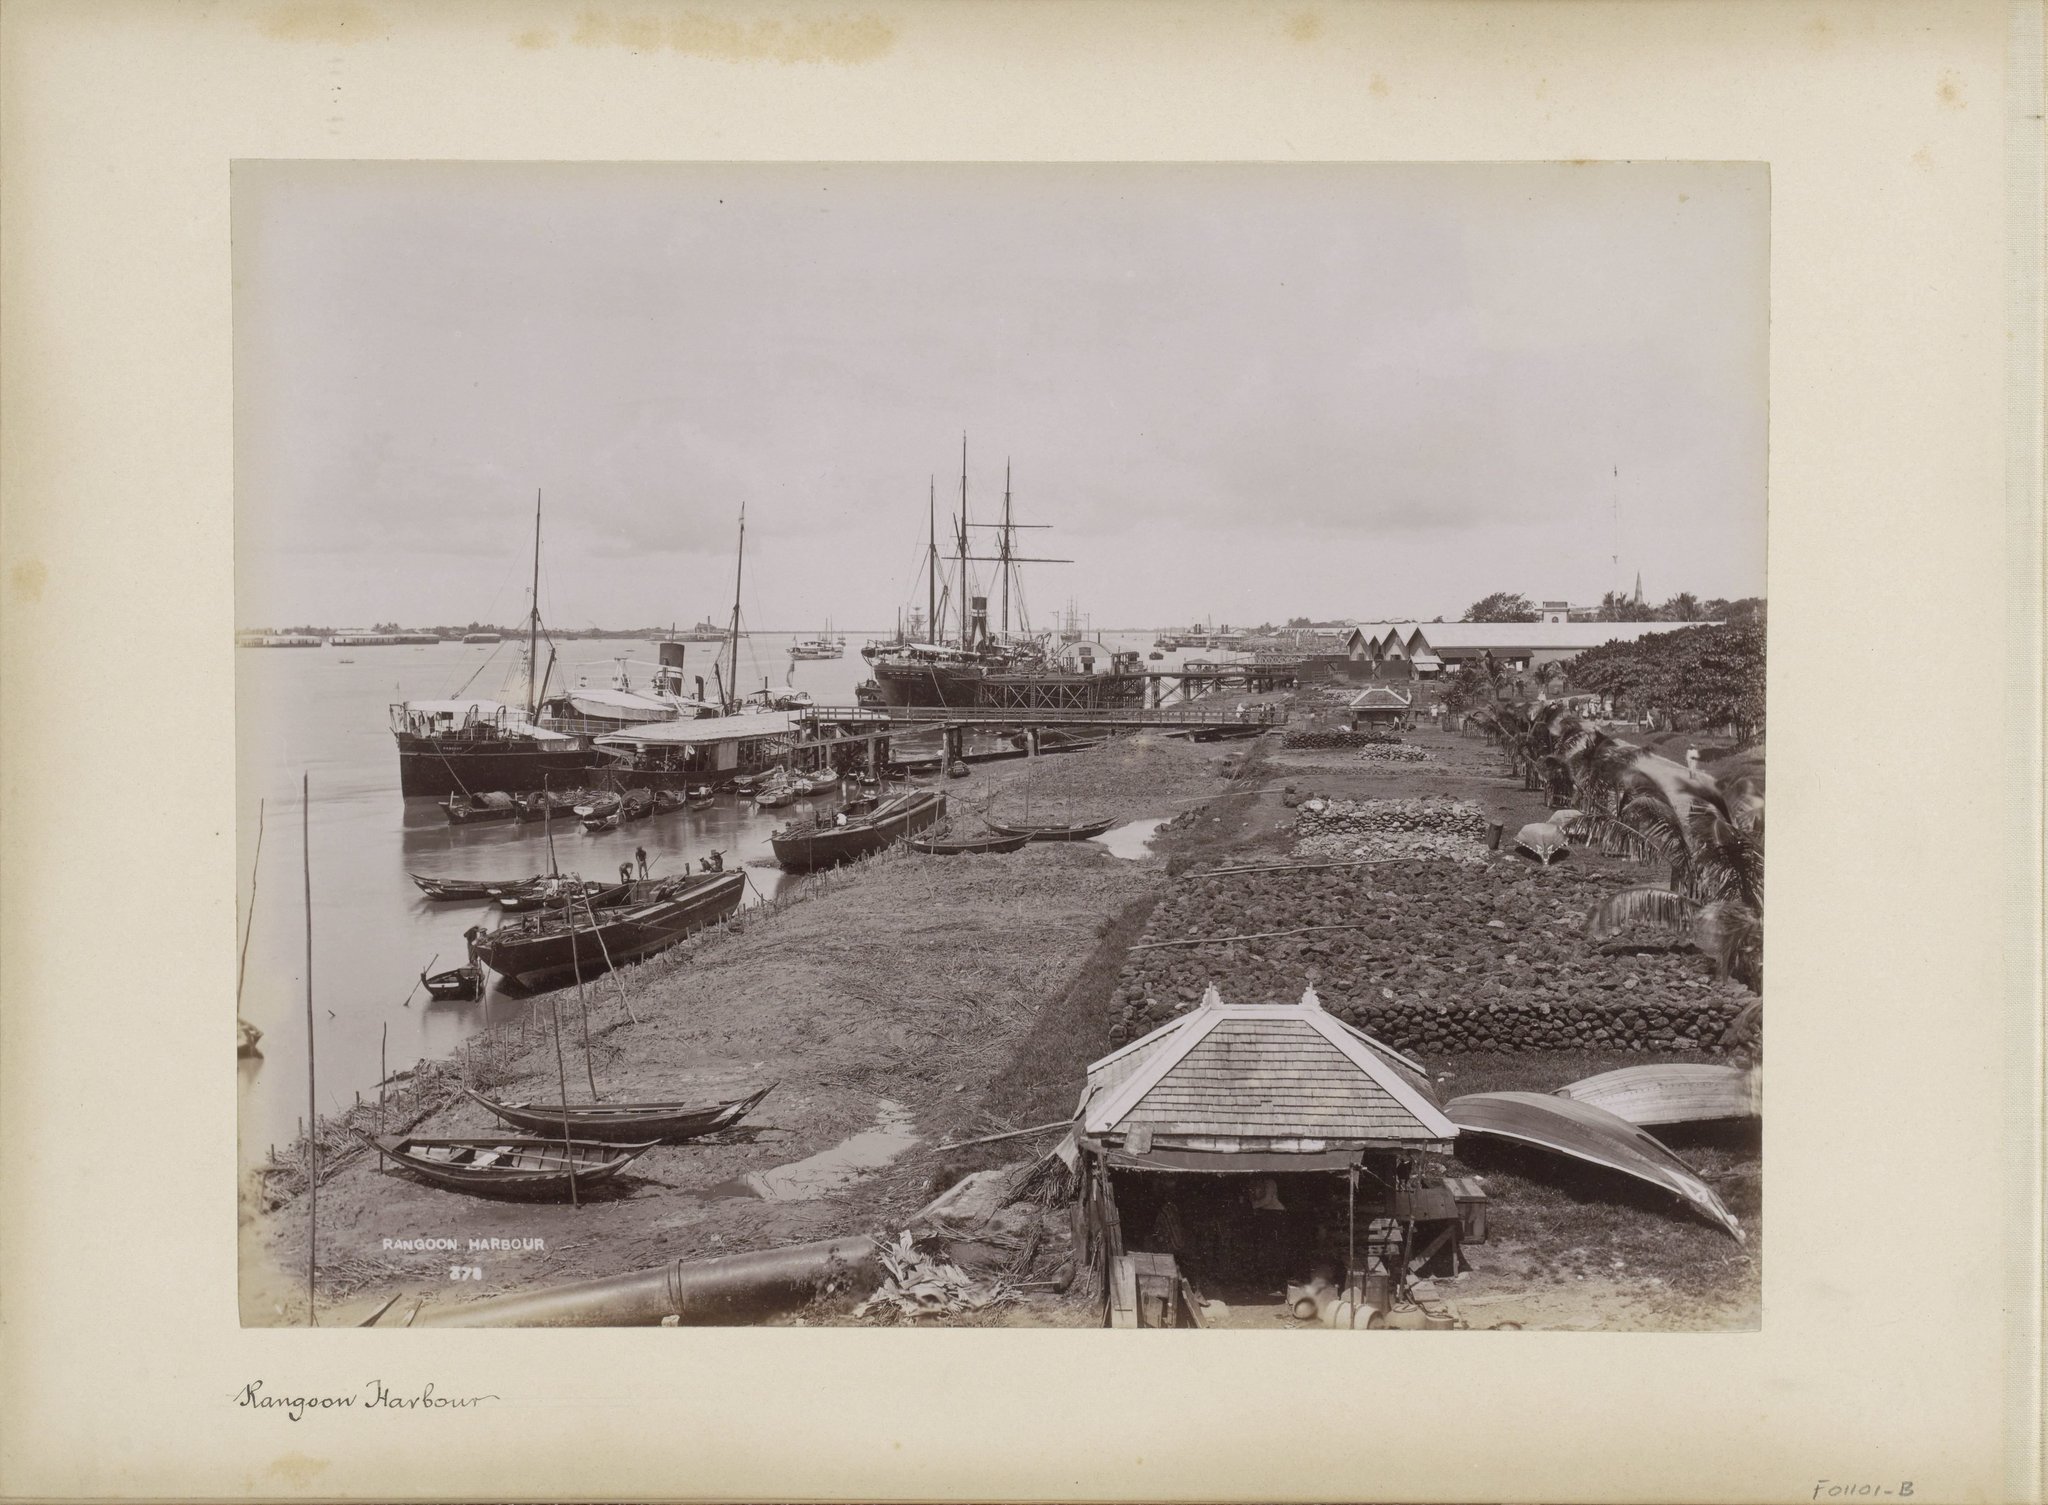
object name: photograph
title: View of the port of Yangon, Myanmar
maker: philip adolphe klier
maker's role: fotograaf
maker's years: 1845-1911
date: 1885-1886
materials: cardboard, paper, photographic support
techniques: albumen print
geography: yangon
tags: harbour (+ view ~ vehicle, ship, etc.), quay (+ city(-scape) with figures, staffage)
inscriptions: number: ‘378’, title: ‘Rangoon Harbour’, caption: ‘Rangoon Harbour’, check stamp: ‘P. Klier Rangoon’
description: Onderdeel van Reisalbum met foto's van bezienswaardigheden in Birma.